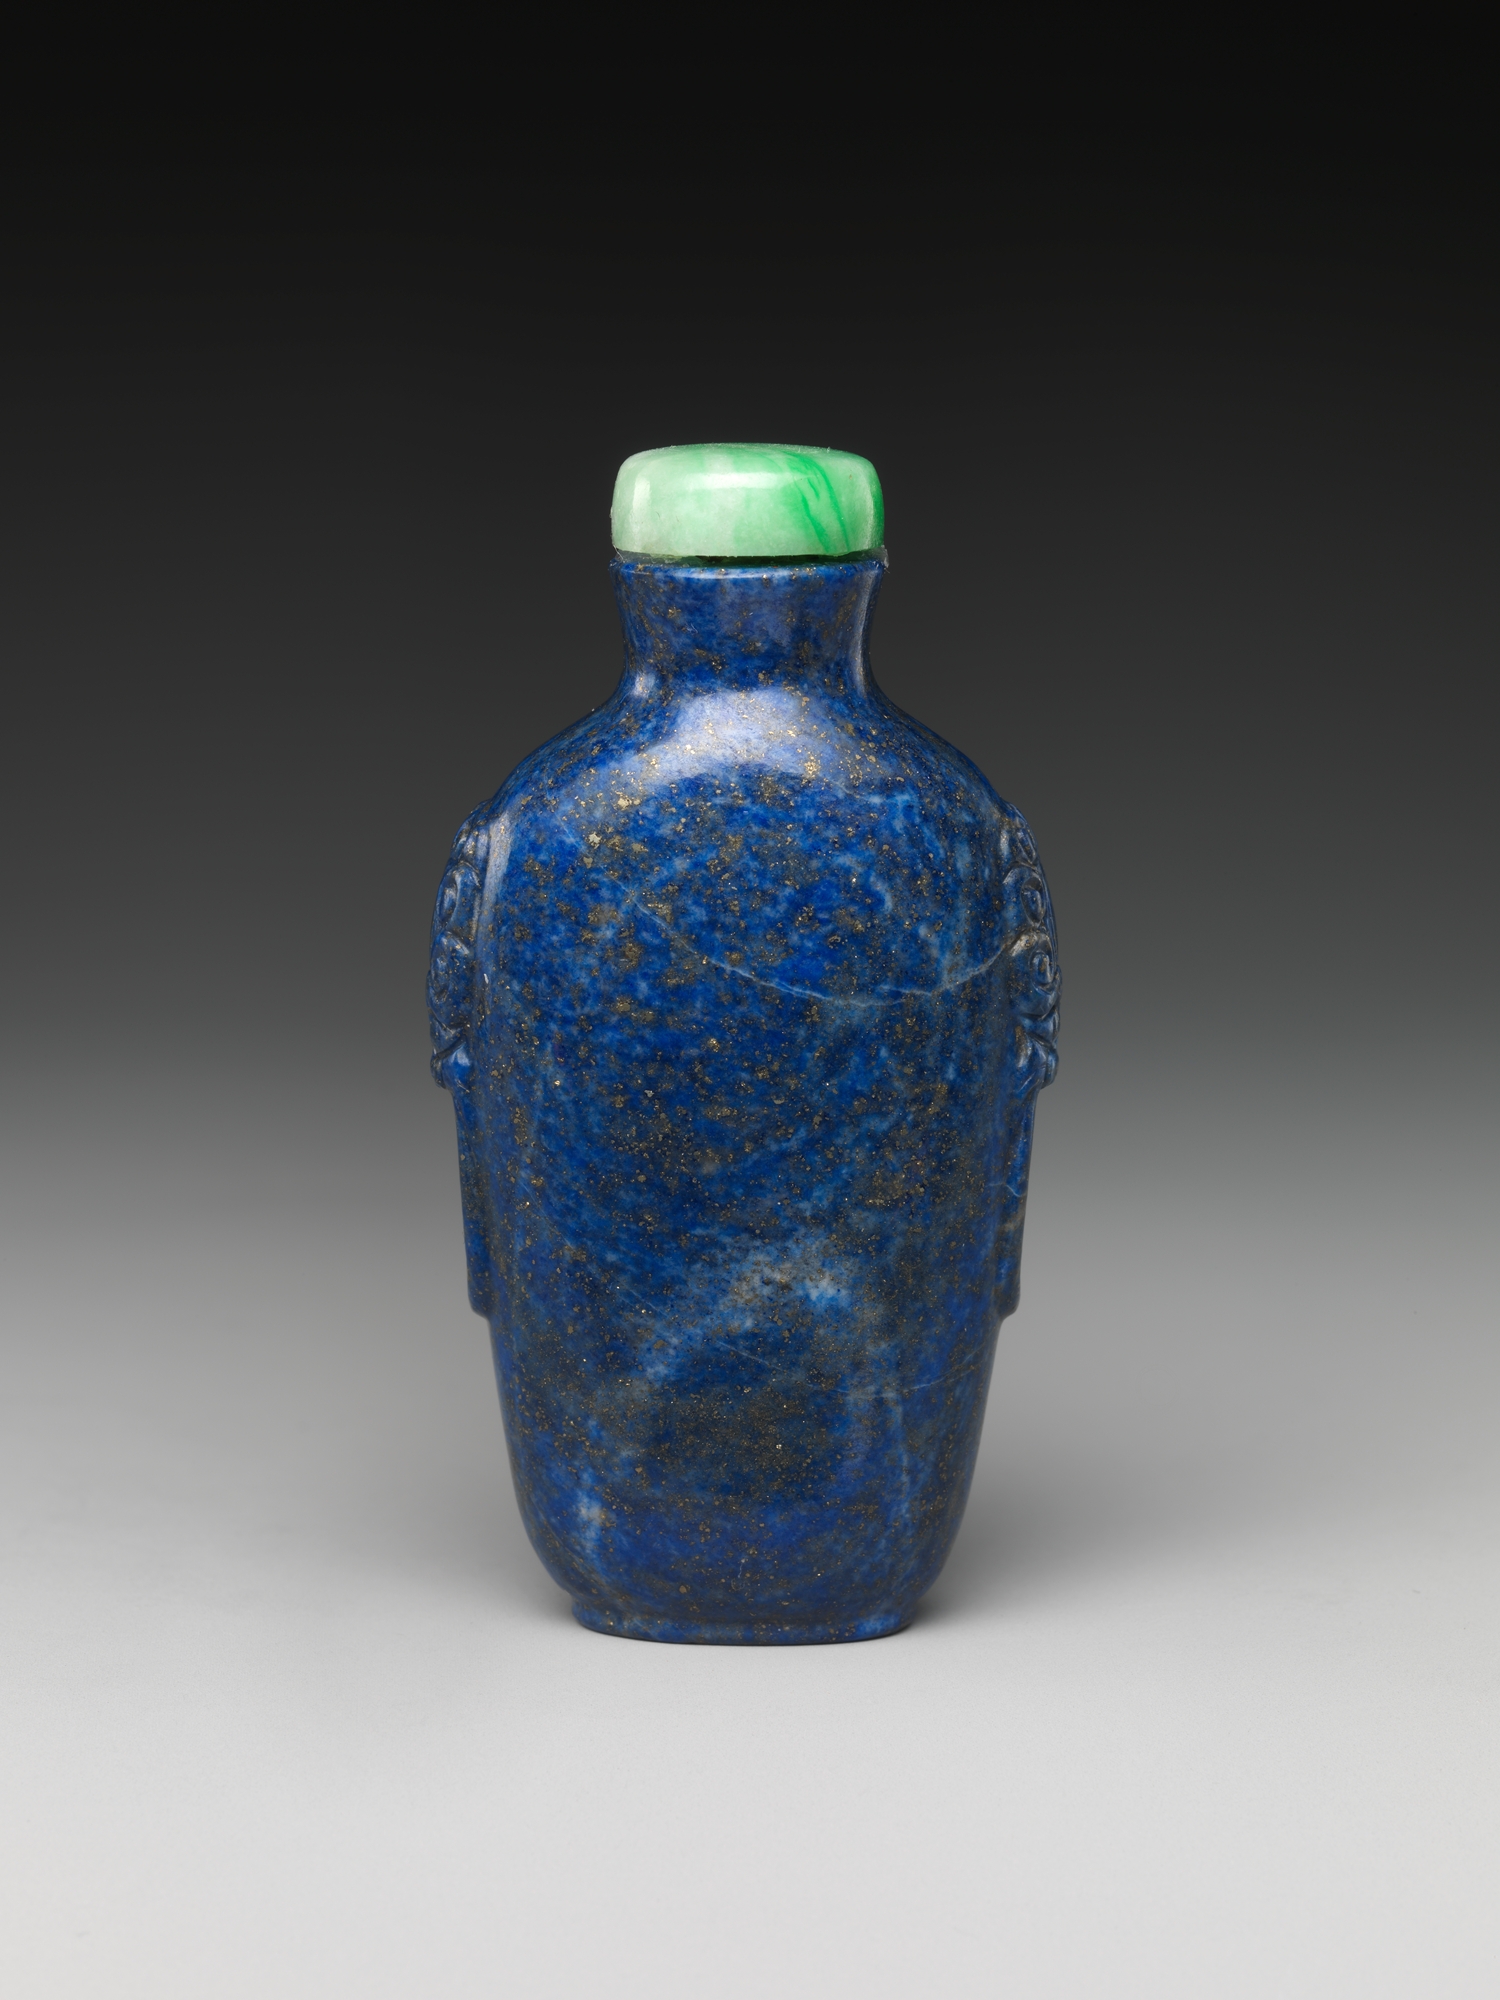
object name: snuff bottle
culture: chinese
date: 1767-1833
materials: jade, lapis lazuli